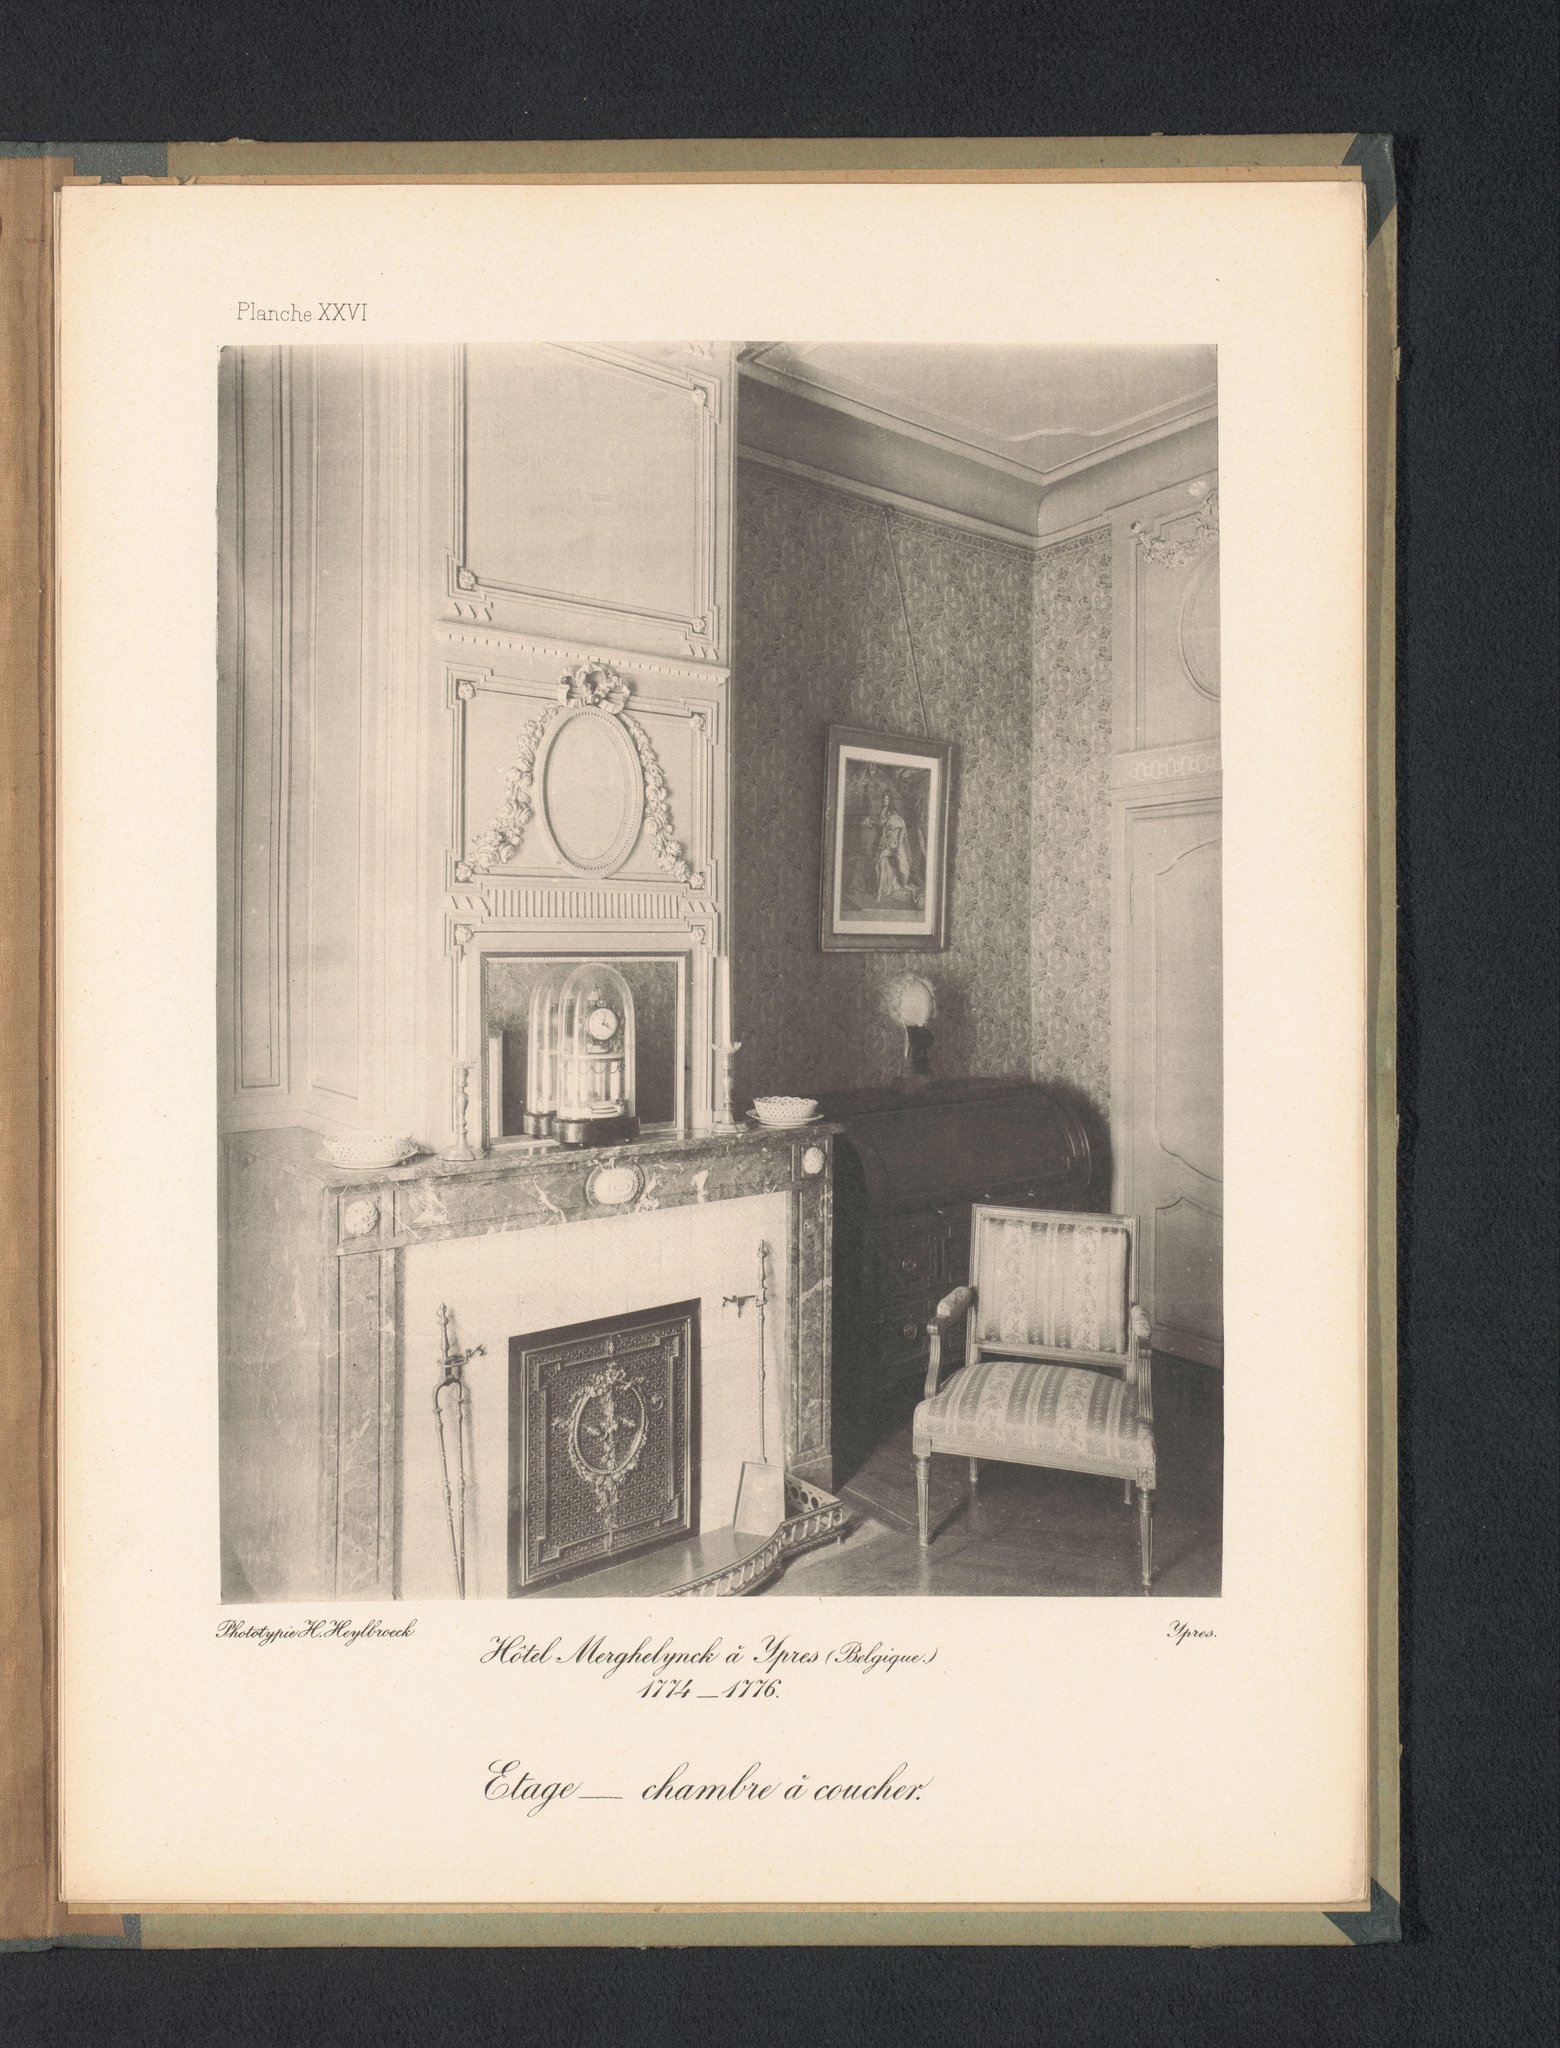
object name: photomechanical print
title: Etage - chambre à coucher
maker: hector heylbroeck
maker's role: fotograaf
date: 1889-1894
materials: paper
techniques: photograph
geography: ieper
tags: hotel, hostelry, inn, bedroom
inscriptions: inscription: ‘Ypres.’, number: ‘Planche XXVI’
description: Deze prent maakt deel uit van een omslag met 31 prenten en een katern met teksten.